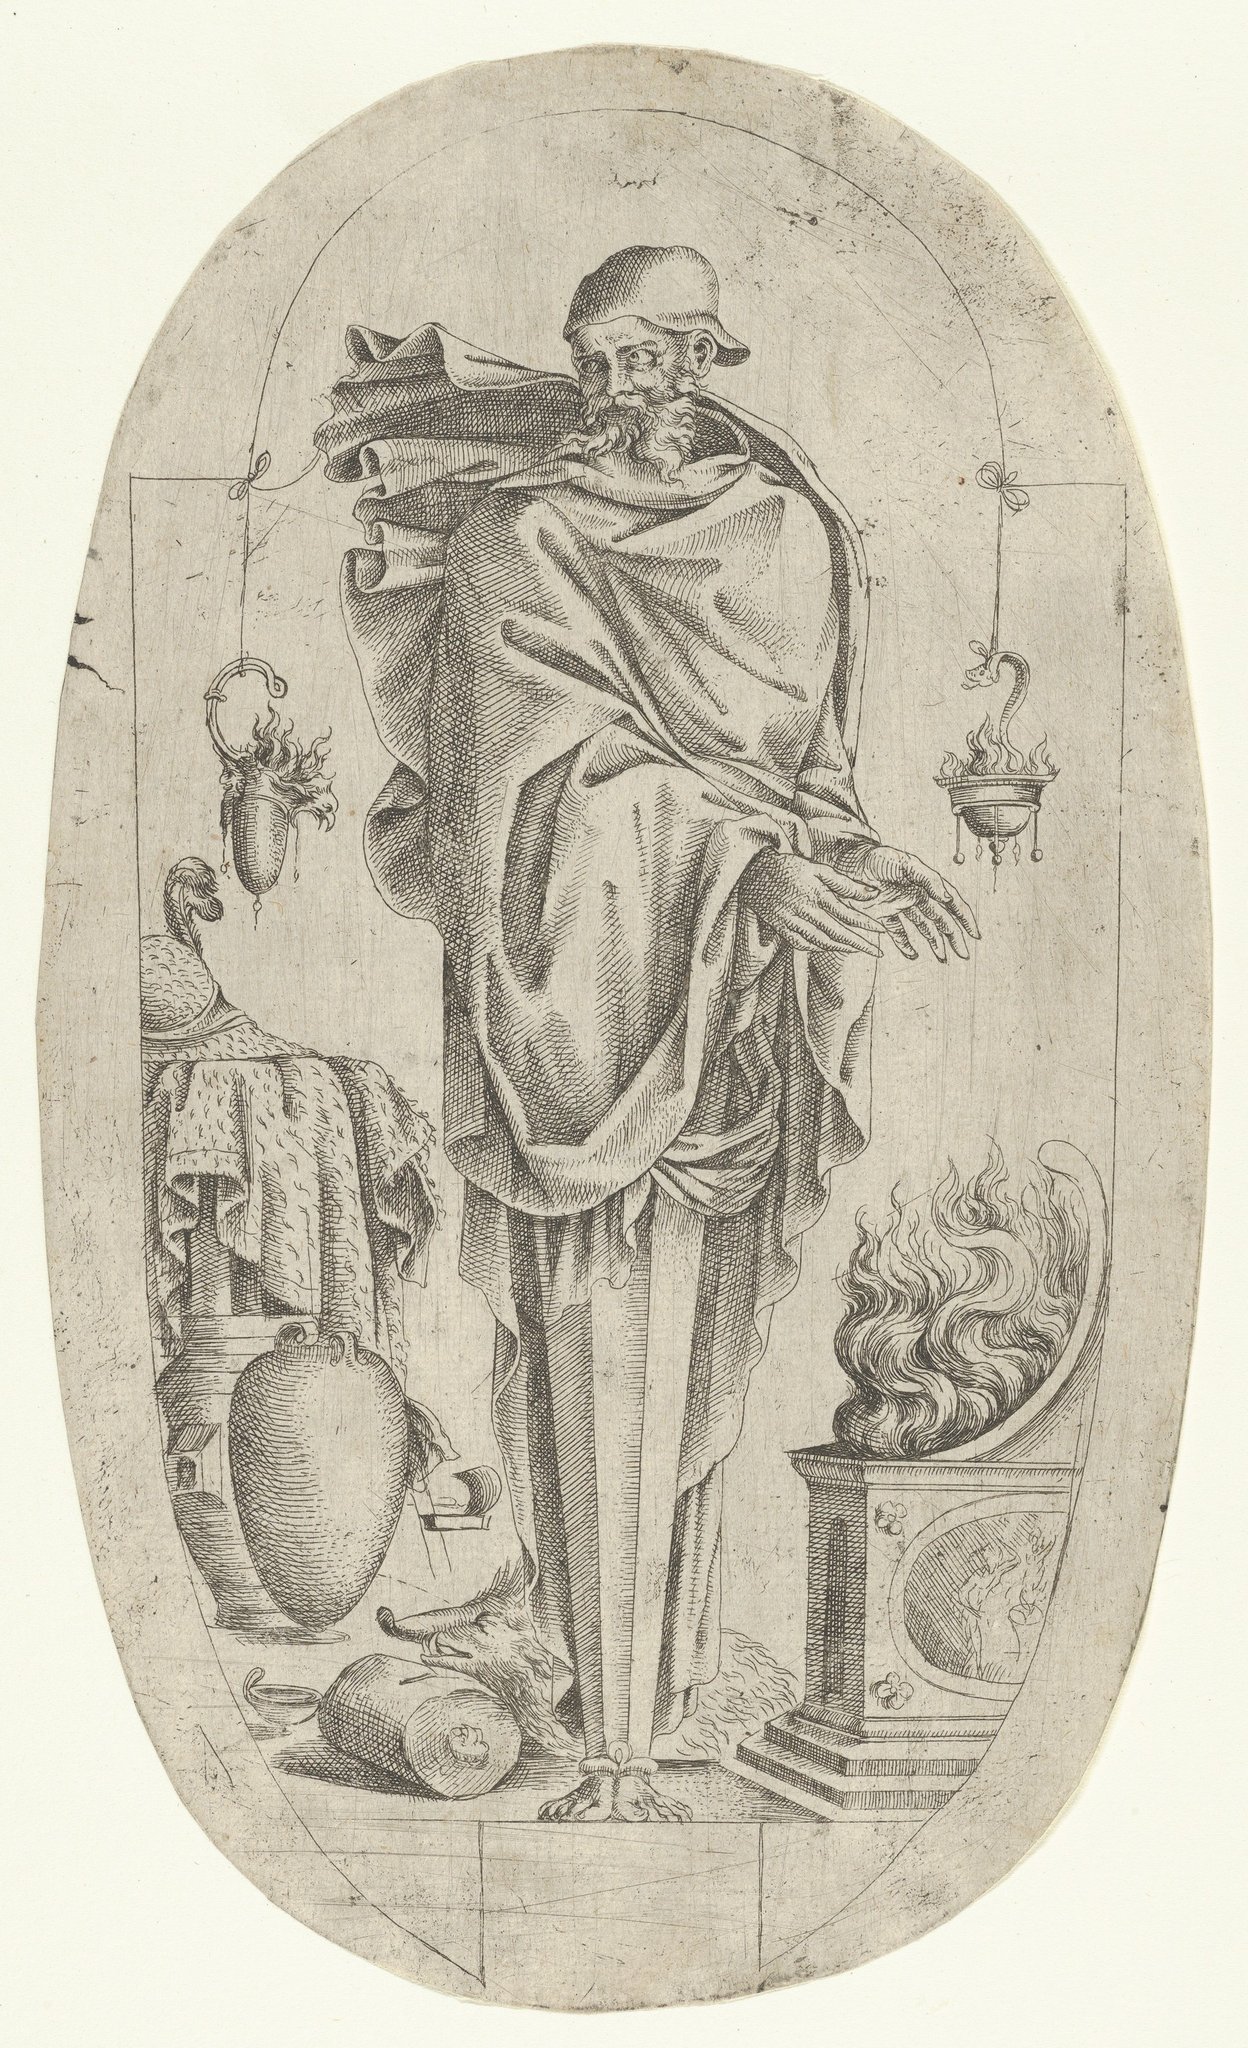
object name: print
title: Term in the Form of an Old Man Warming His Hands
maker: jean mignon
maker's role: artist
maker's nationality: french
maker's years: 1535-1555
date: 1535-1555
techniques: etching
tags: men,fire